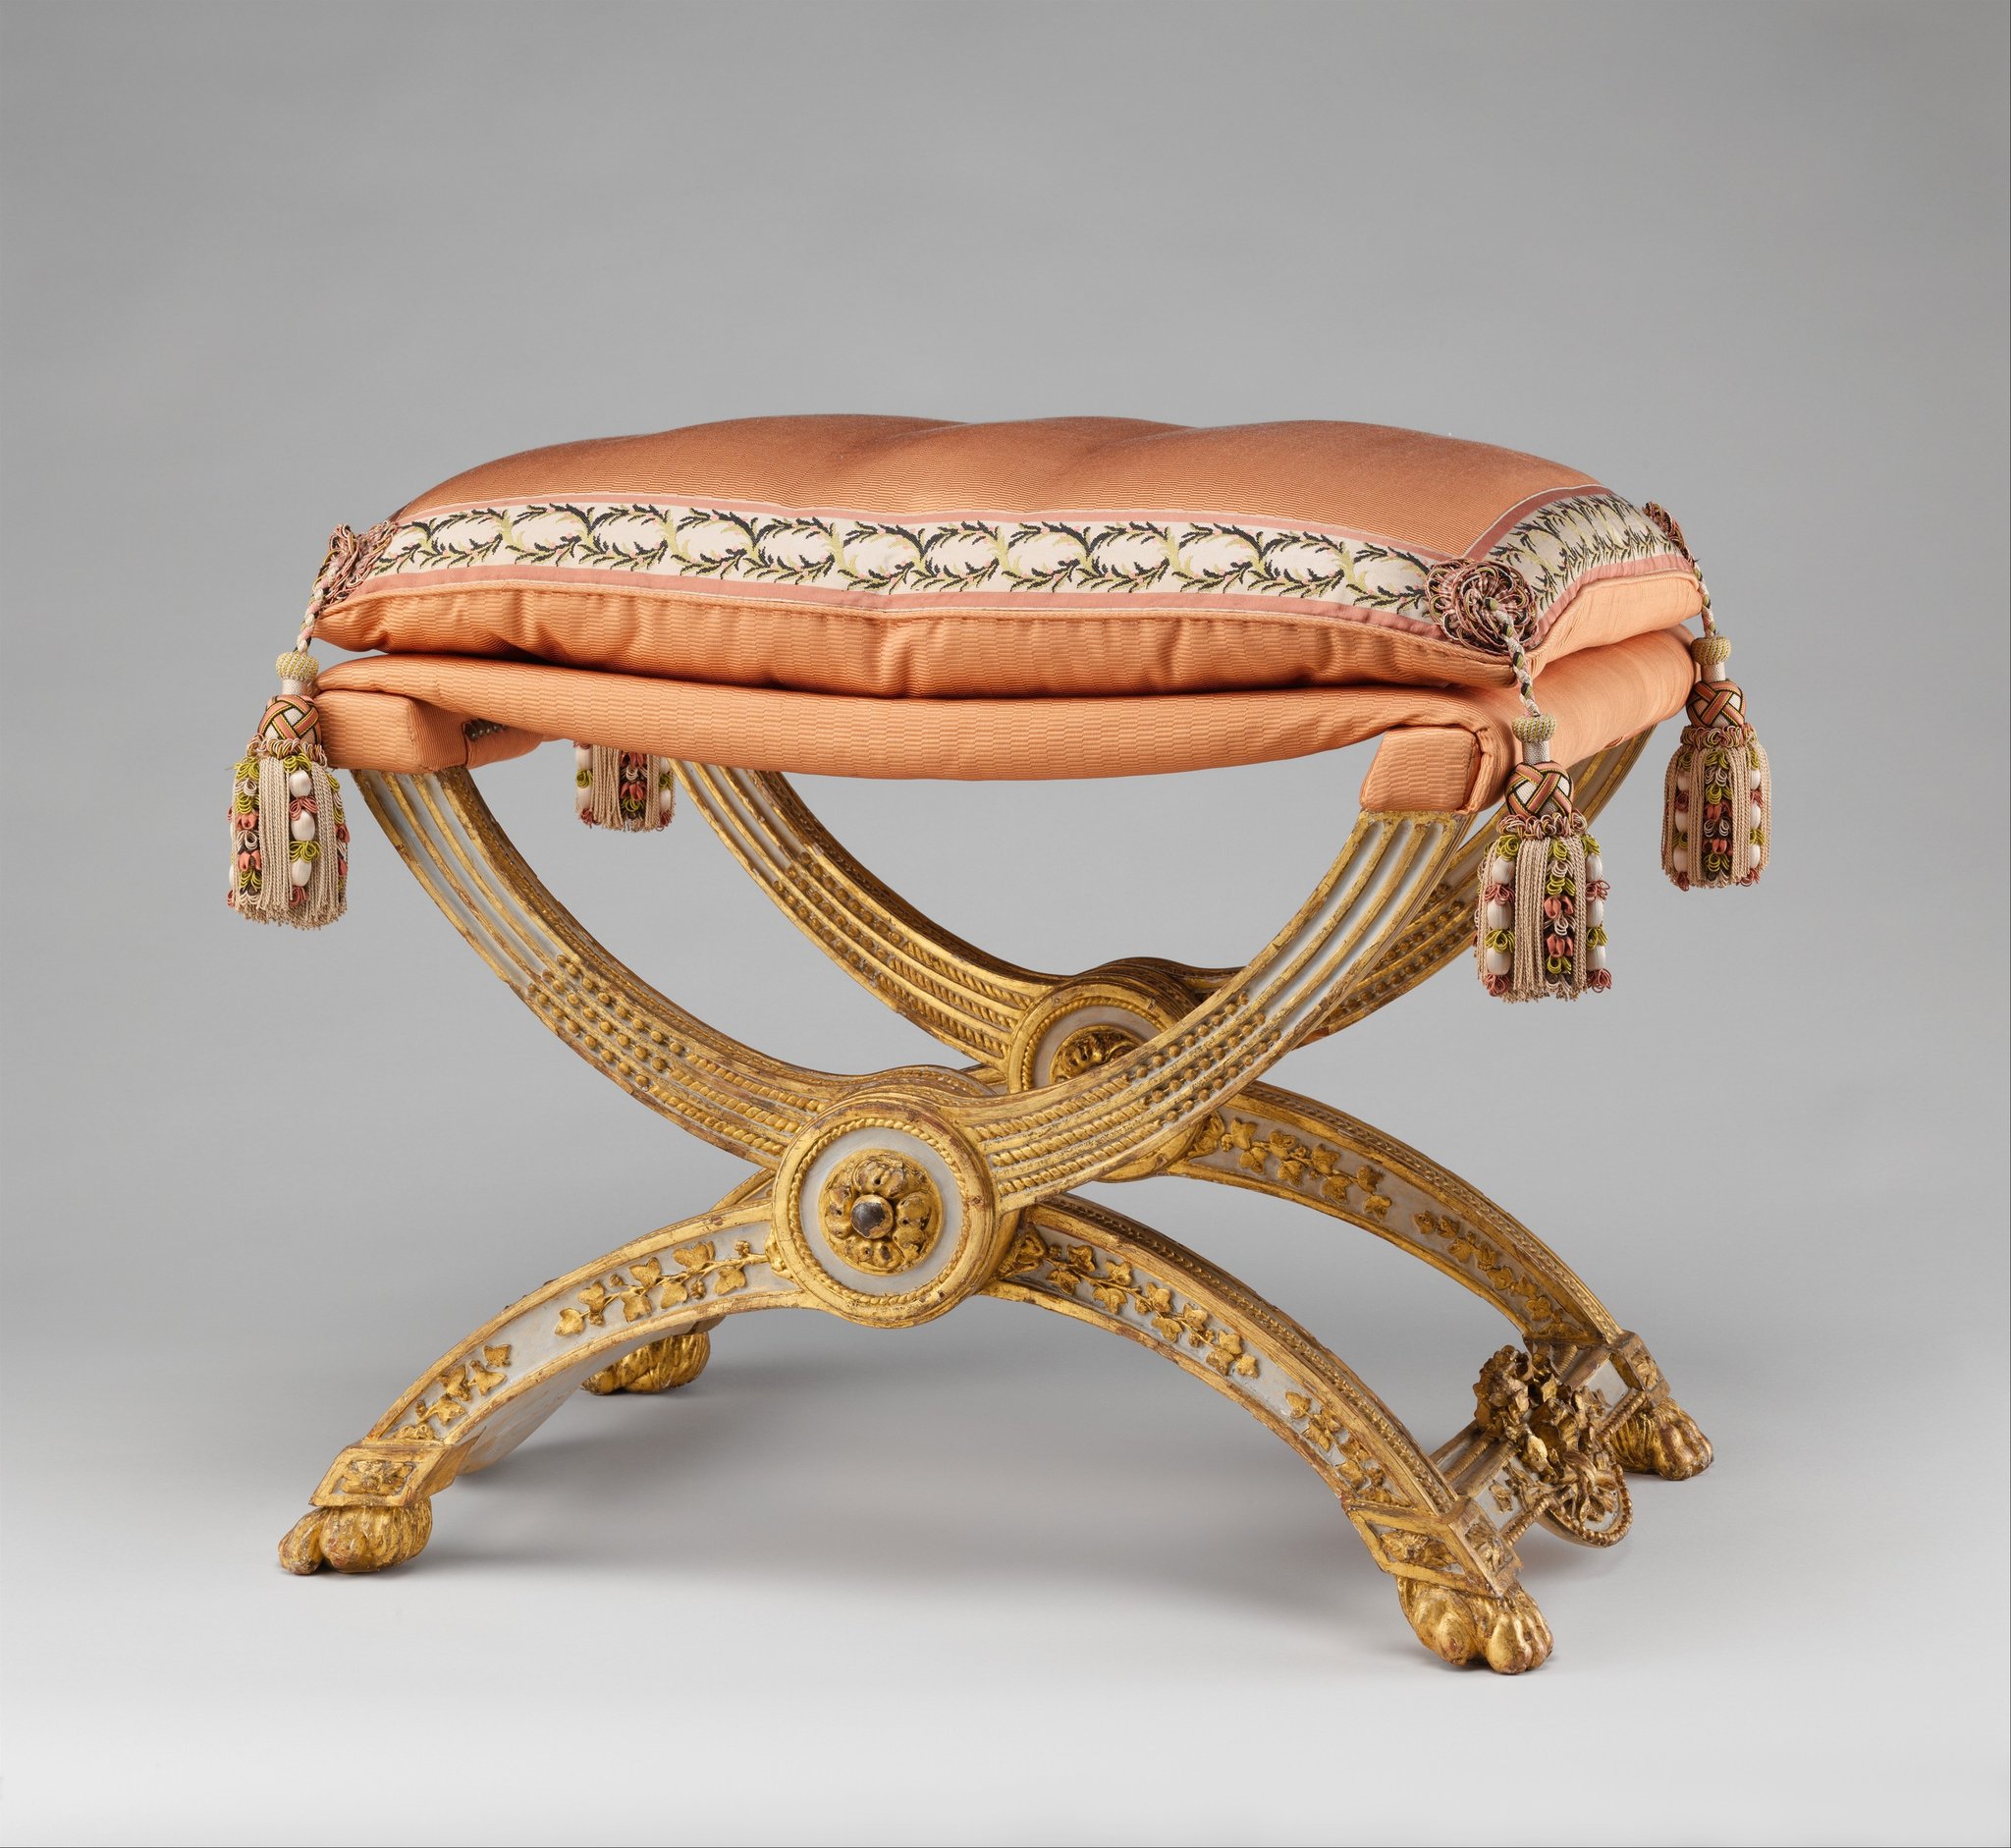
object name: folding stool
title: Folding stool (pliant) (one of a pair)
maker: jean-baptiste-claude sené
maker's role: maker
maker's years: 1748-1803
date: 1786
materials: wood, silk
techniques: carving, painting